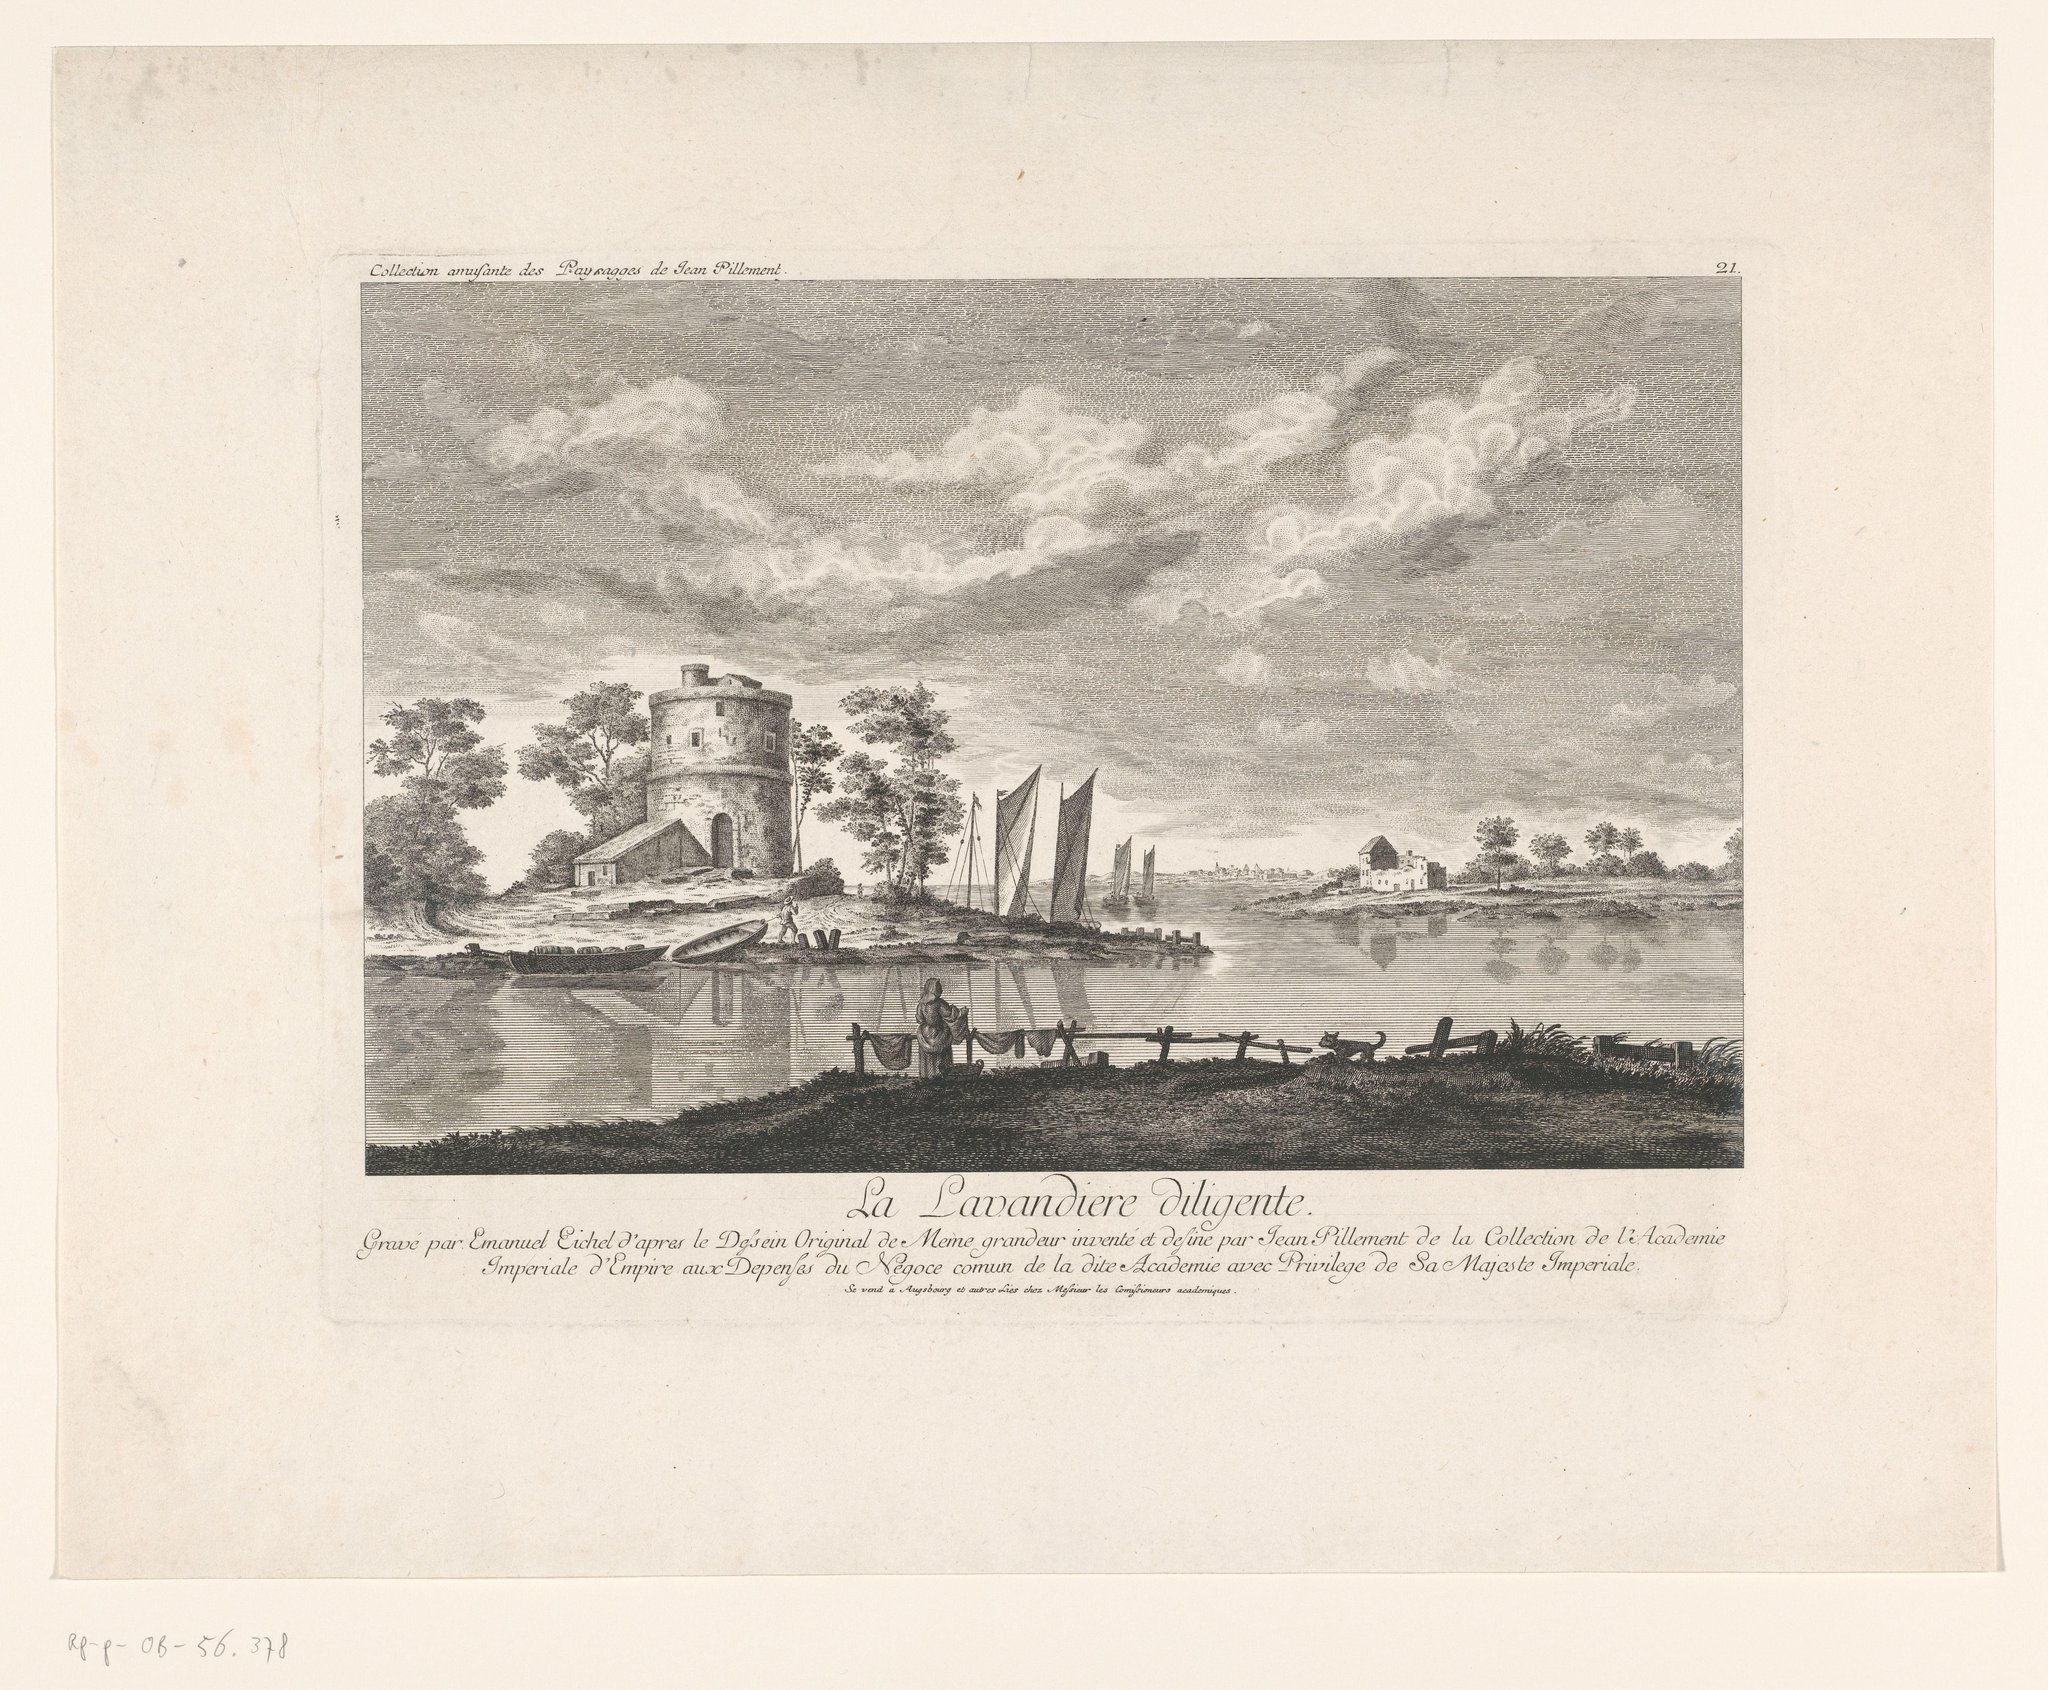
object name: print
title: Rivierlandschap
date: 1727-1782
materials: paper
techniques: etching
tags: landscapes with waters, waterscapes, seascapes (in the temperate zone)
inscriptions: collector's mark: Lugt 2228